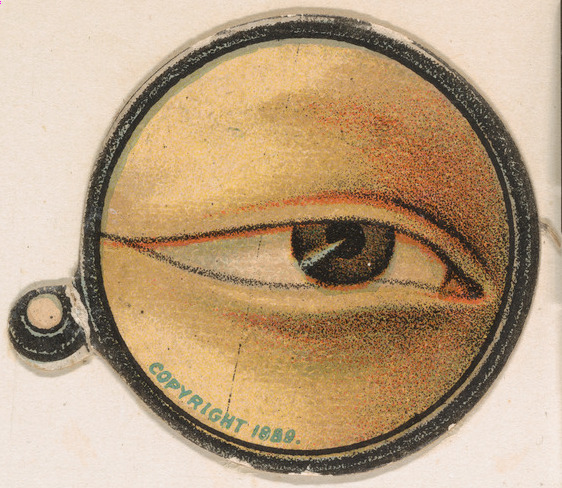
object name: print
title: Monocle and Eye (brown), from Jocular Ocular series (N221) issued by Kinney Bros.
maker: kinney brothers tobacco company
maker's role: publisher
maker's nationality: american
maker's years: 1869-2011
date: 1889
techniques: color lithograph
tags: eyes